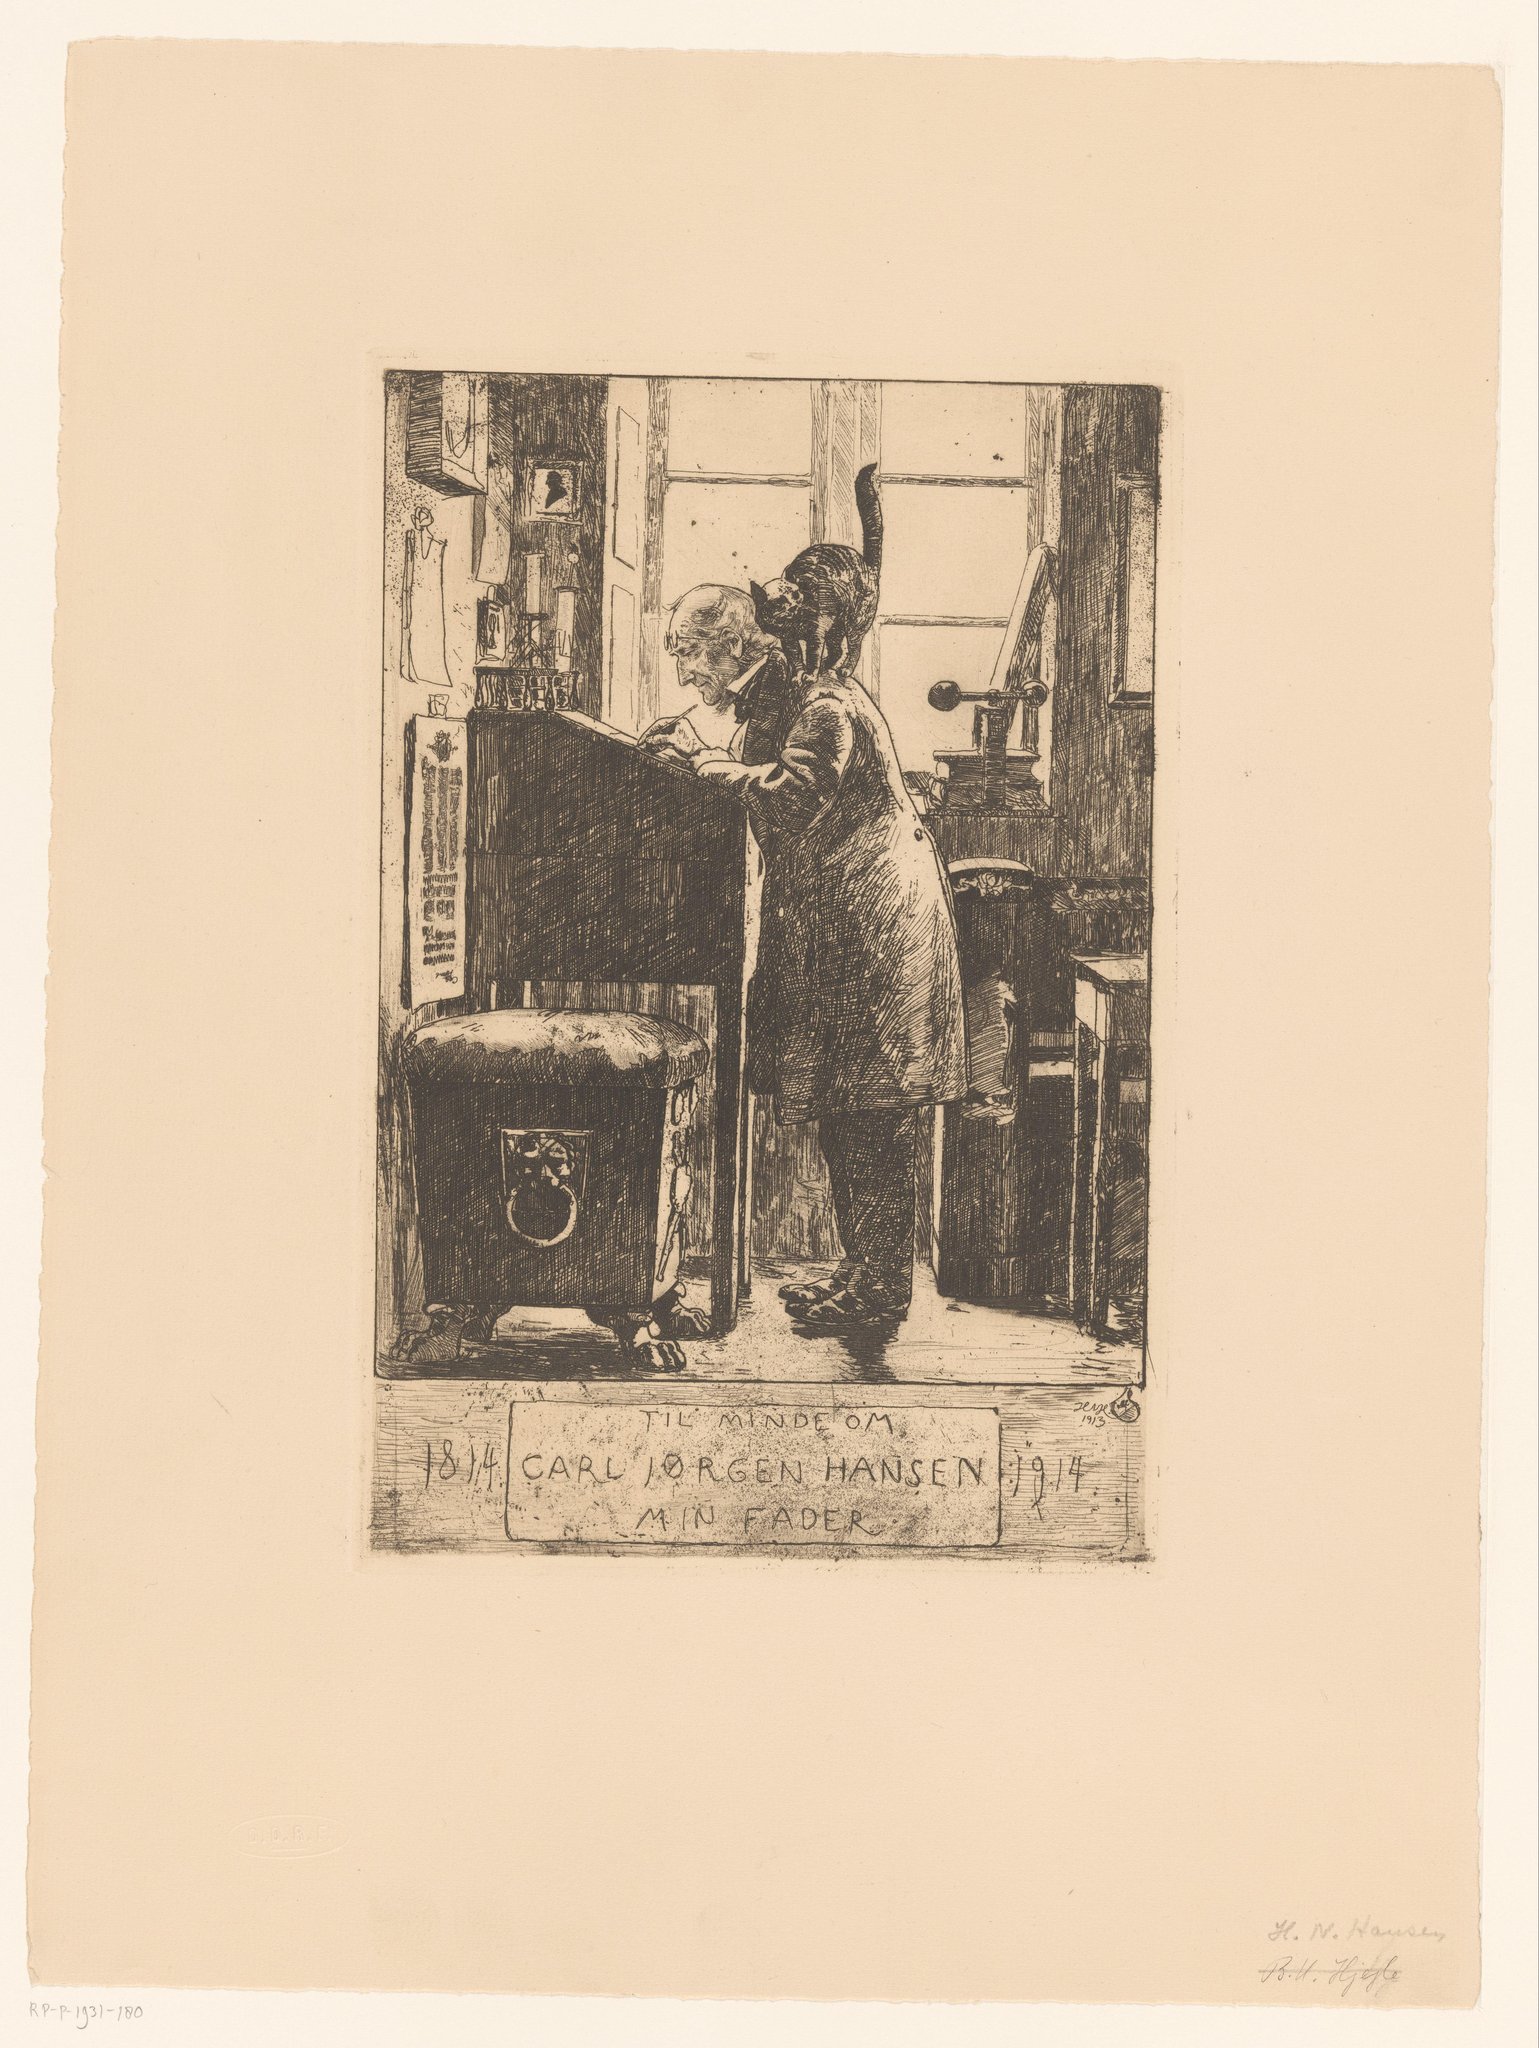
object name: print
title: Vader van de kunstenaar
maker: hans nicolai aksel hansen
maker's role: painter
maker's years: 1853-1923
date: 1913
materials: paper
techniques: drypoint, etching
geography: denmark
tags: historical persons, old man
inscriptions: collector's mark: Lugt 2228, collector's mark: ‘D.D.R.F’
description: Portret van Carl Jorgen Hansen, de vader van de kunstenaar, als een oude boekhouder schrijvend achter een kansel.